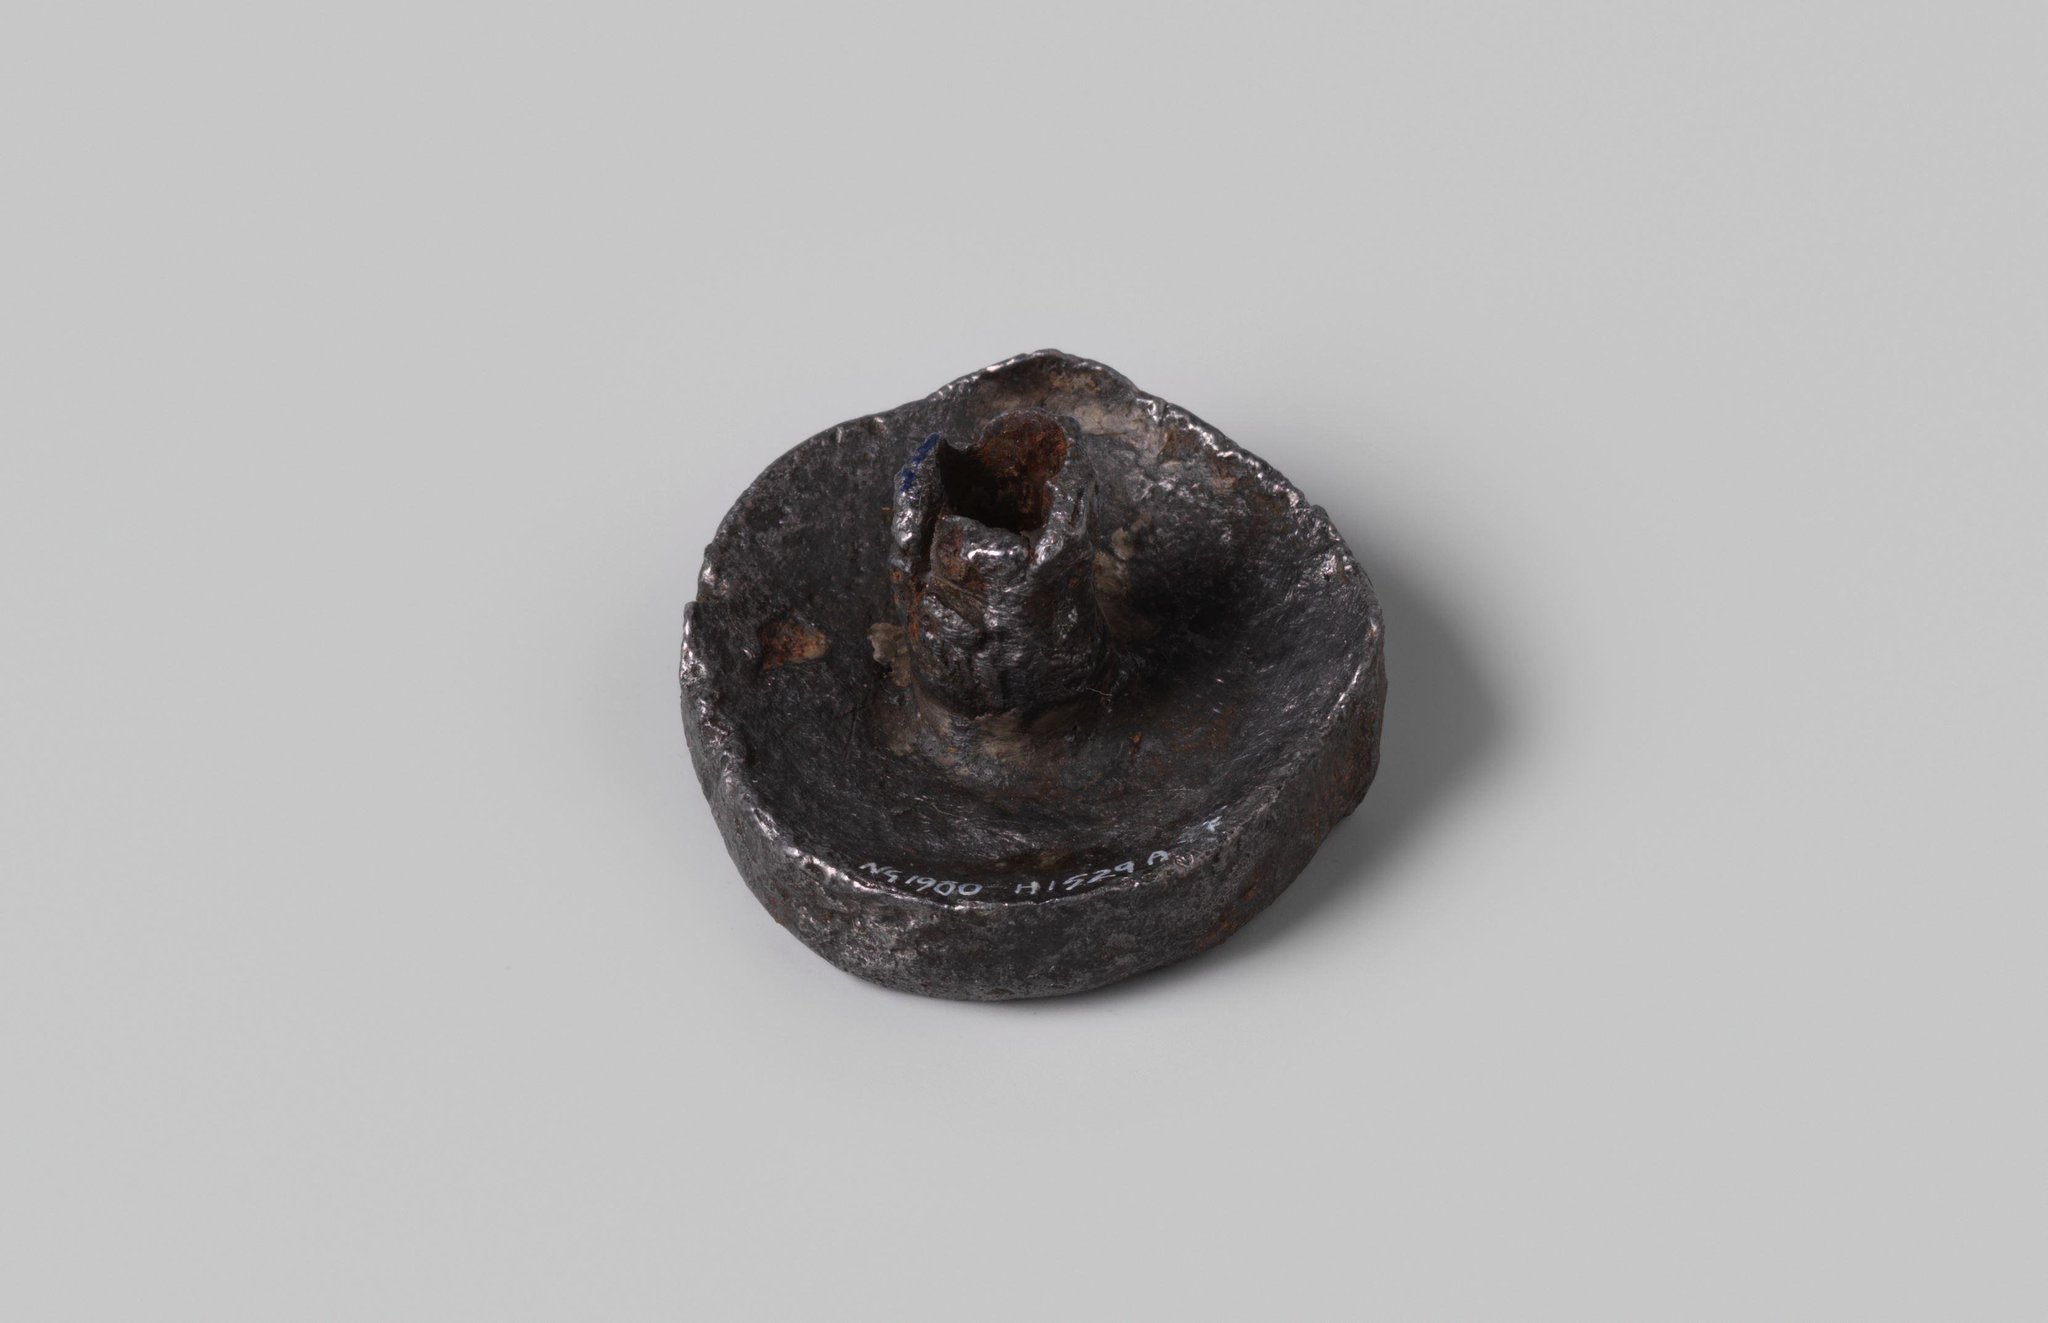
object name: weight scale component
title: Lead weight from the wreck of the Dutch East India ship Hollandia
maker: Anonymous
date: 1700-1743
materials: lead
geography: netherlands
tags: verenigde oostindische compagnie, hollandia (schip), annet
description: Ring-handle weight, top, circular disc, concave underneath with hollow shaft in centre, flat top with 2 holes for handle and inscription (I).